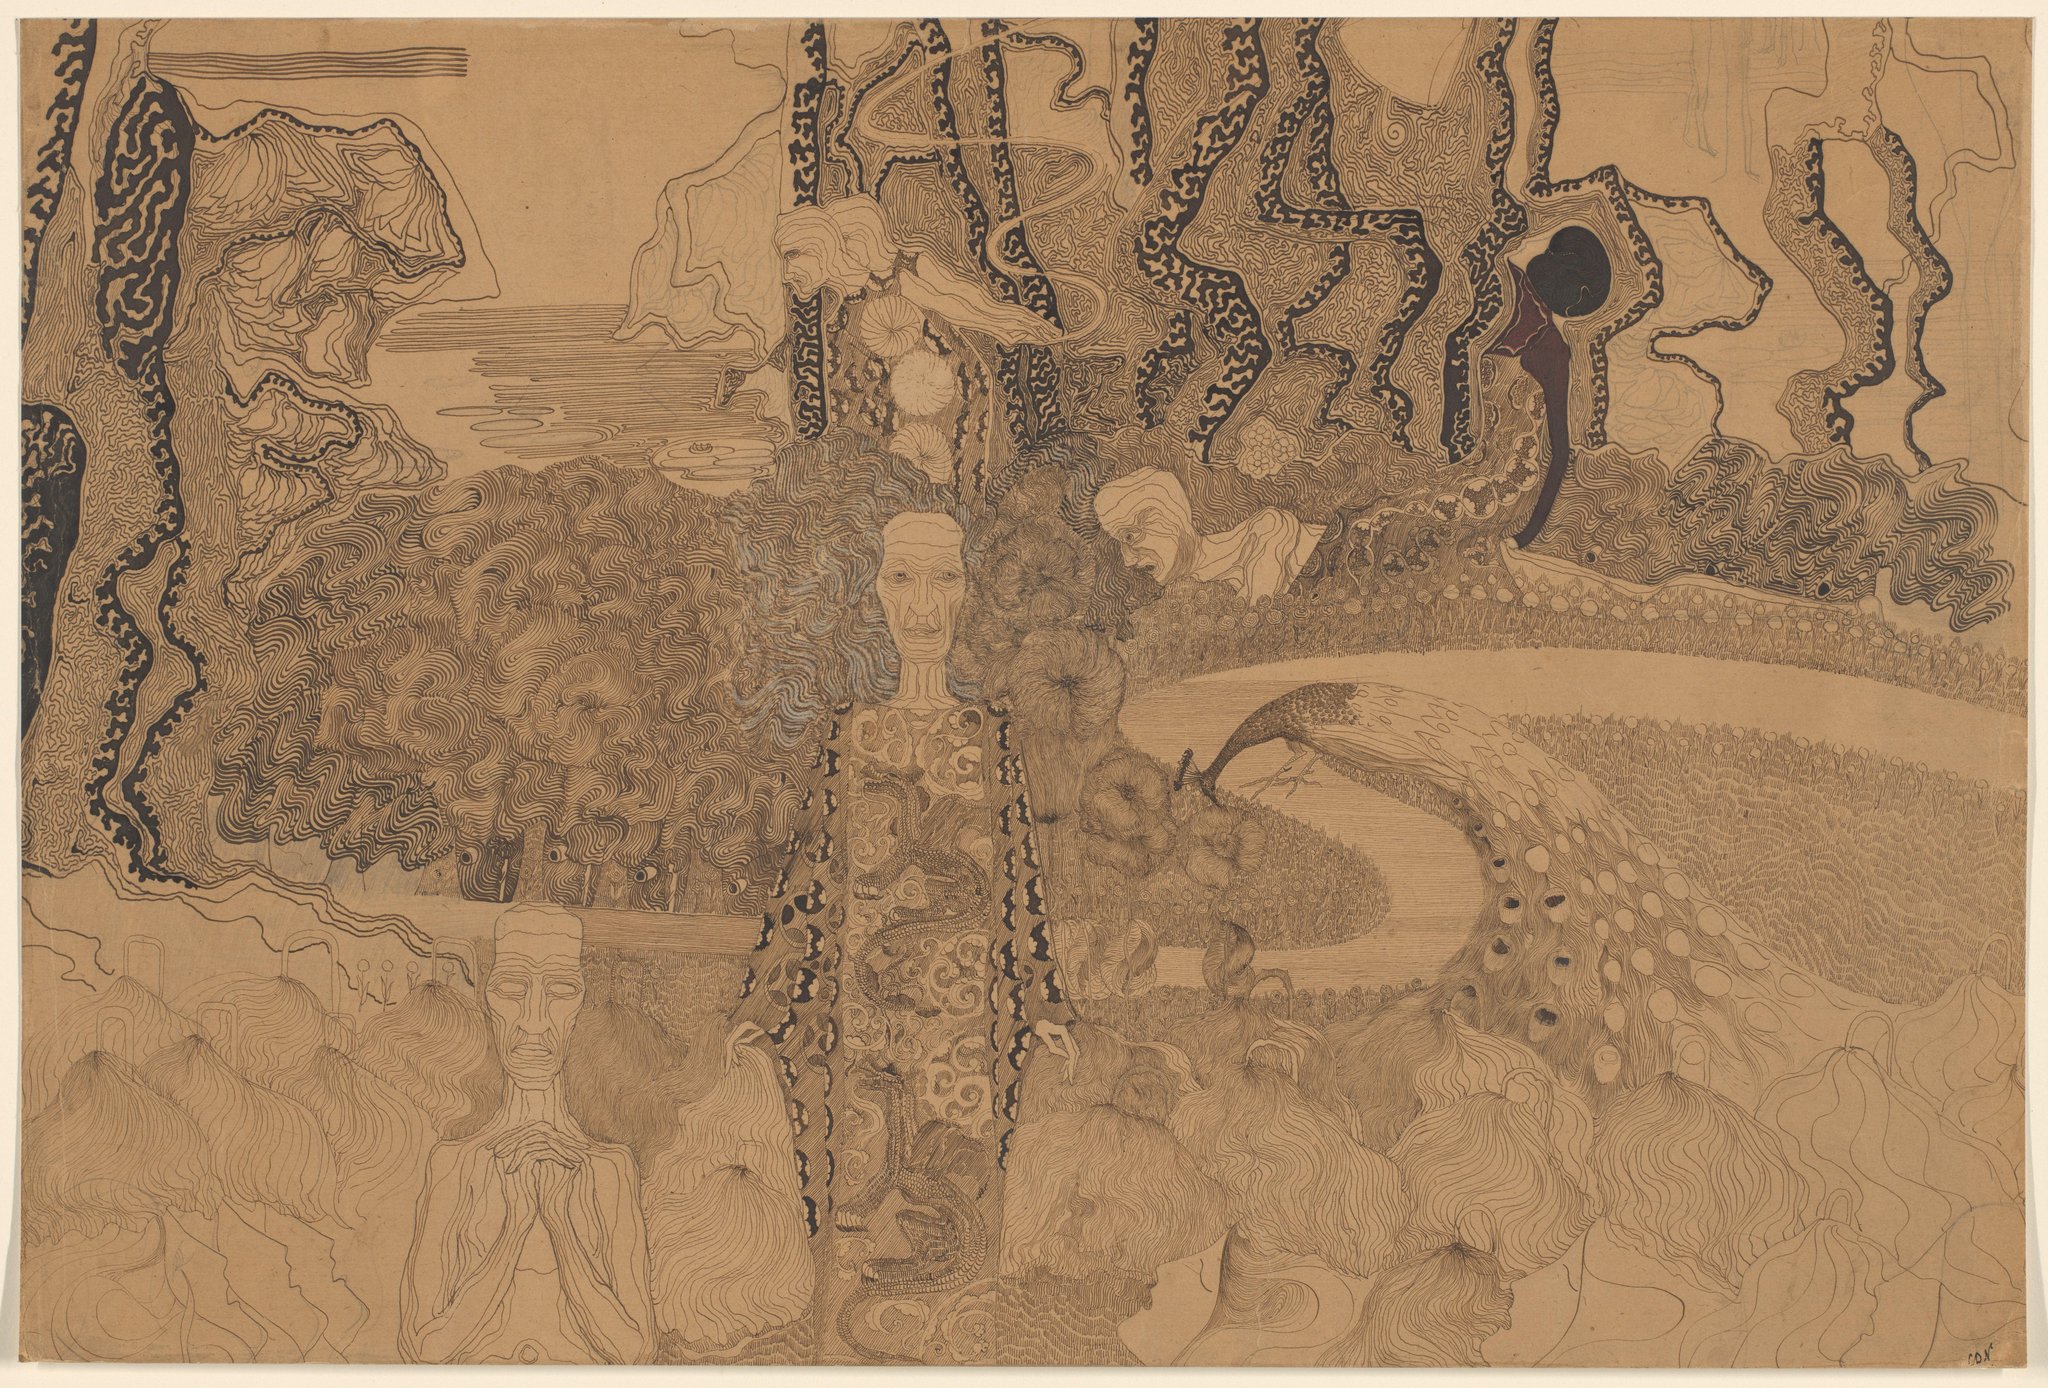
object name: drawing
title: Allegorische voorstelling met figuren en een pauw in een tuin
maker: karel de nerée tot babberich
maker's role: draughtsman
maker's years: 1880-1909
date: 1890-1909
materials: chalk, paint, ink, paper, pencil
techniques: brush, pen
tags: garden, ornamental birds: peacock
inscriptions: collector's mark: Lugt 2228